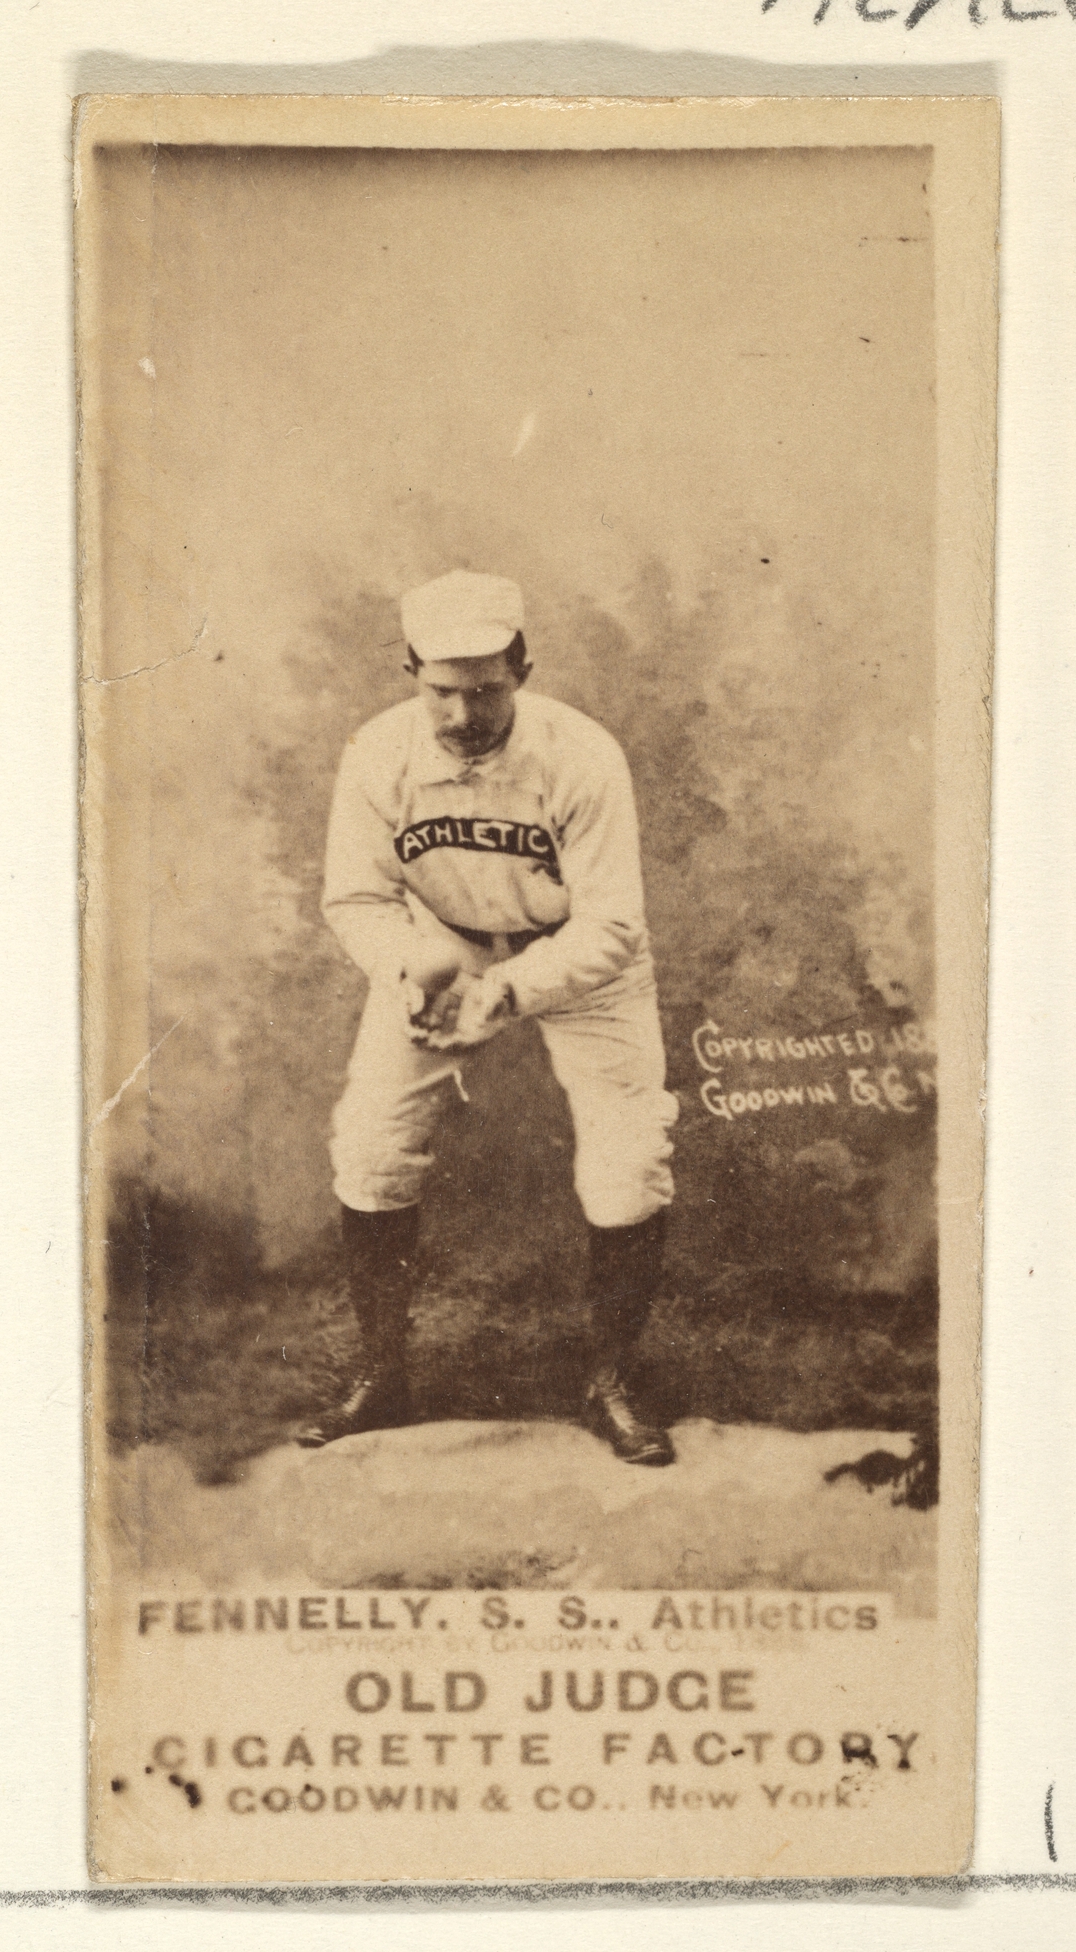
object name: baseball card, photograph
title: Fennelly, Shortstop, Philadelphia Athletics, from the Old Judge series (N172) for Old Judge Cigarettes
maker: goodwin & company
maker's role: publisher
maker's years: 1850-1950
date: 1887-1890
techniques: albumen silver print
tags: men,portraits,baseball,athletes